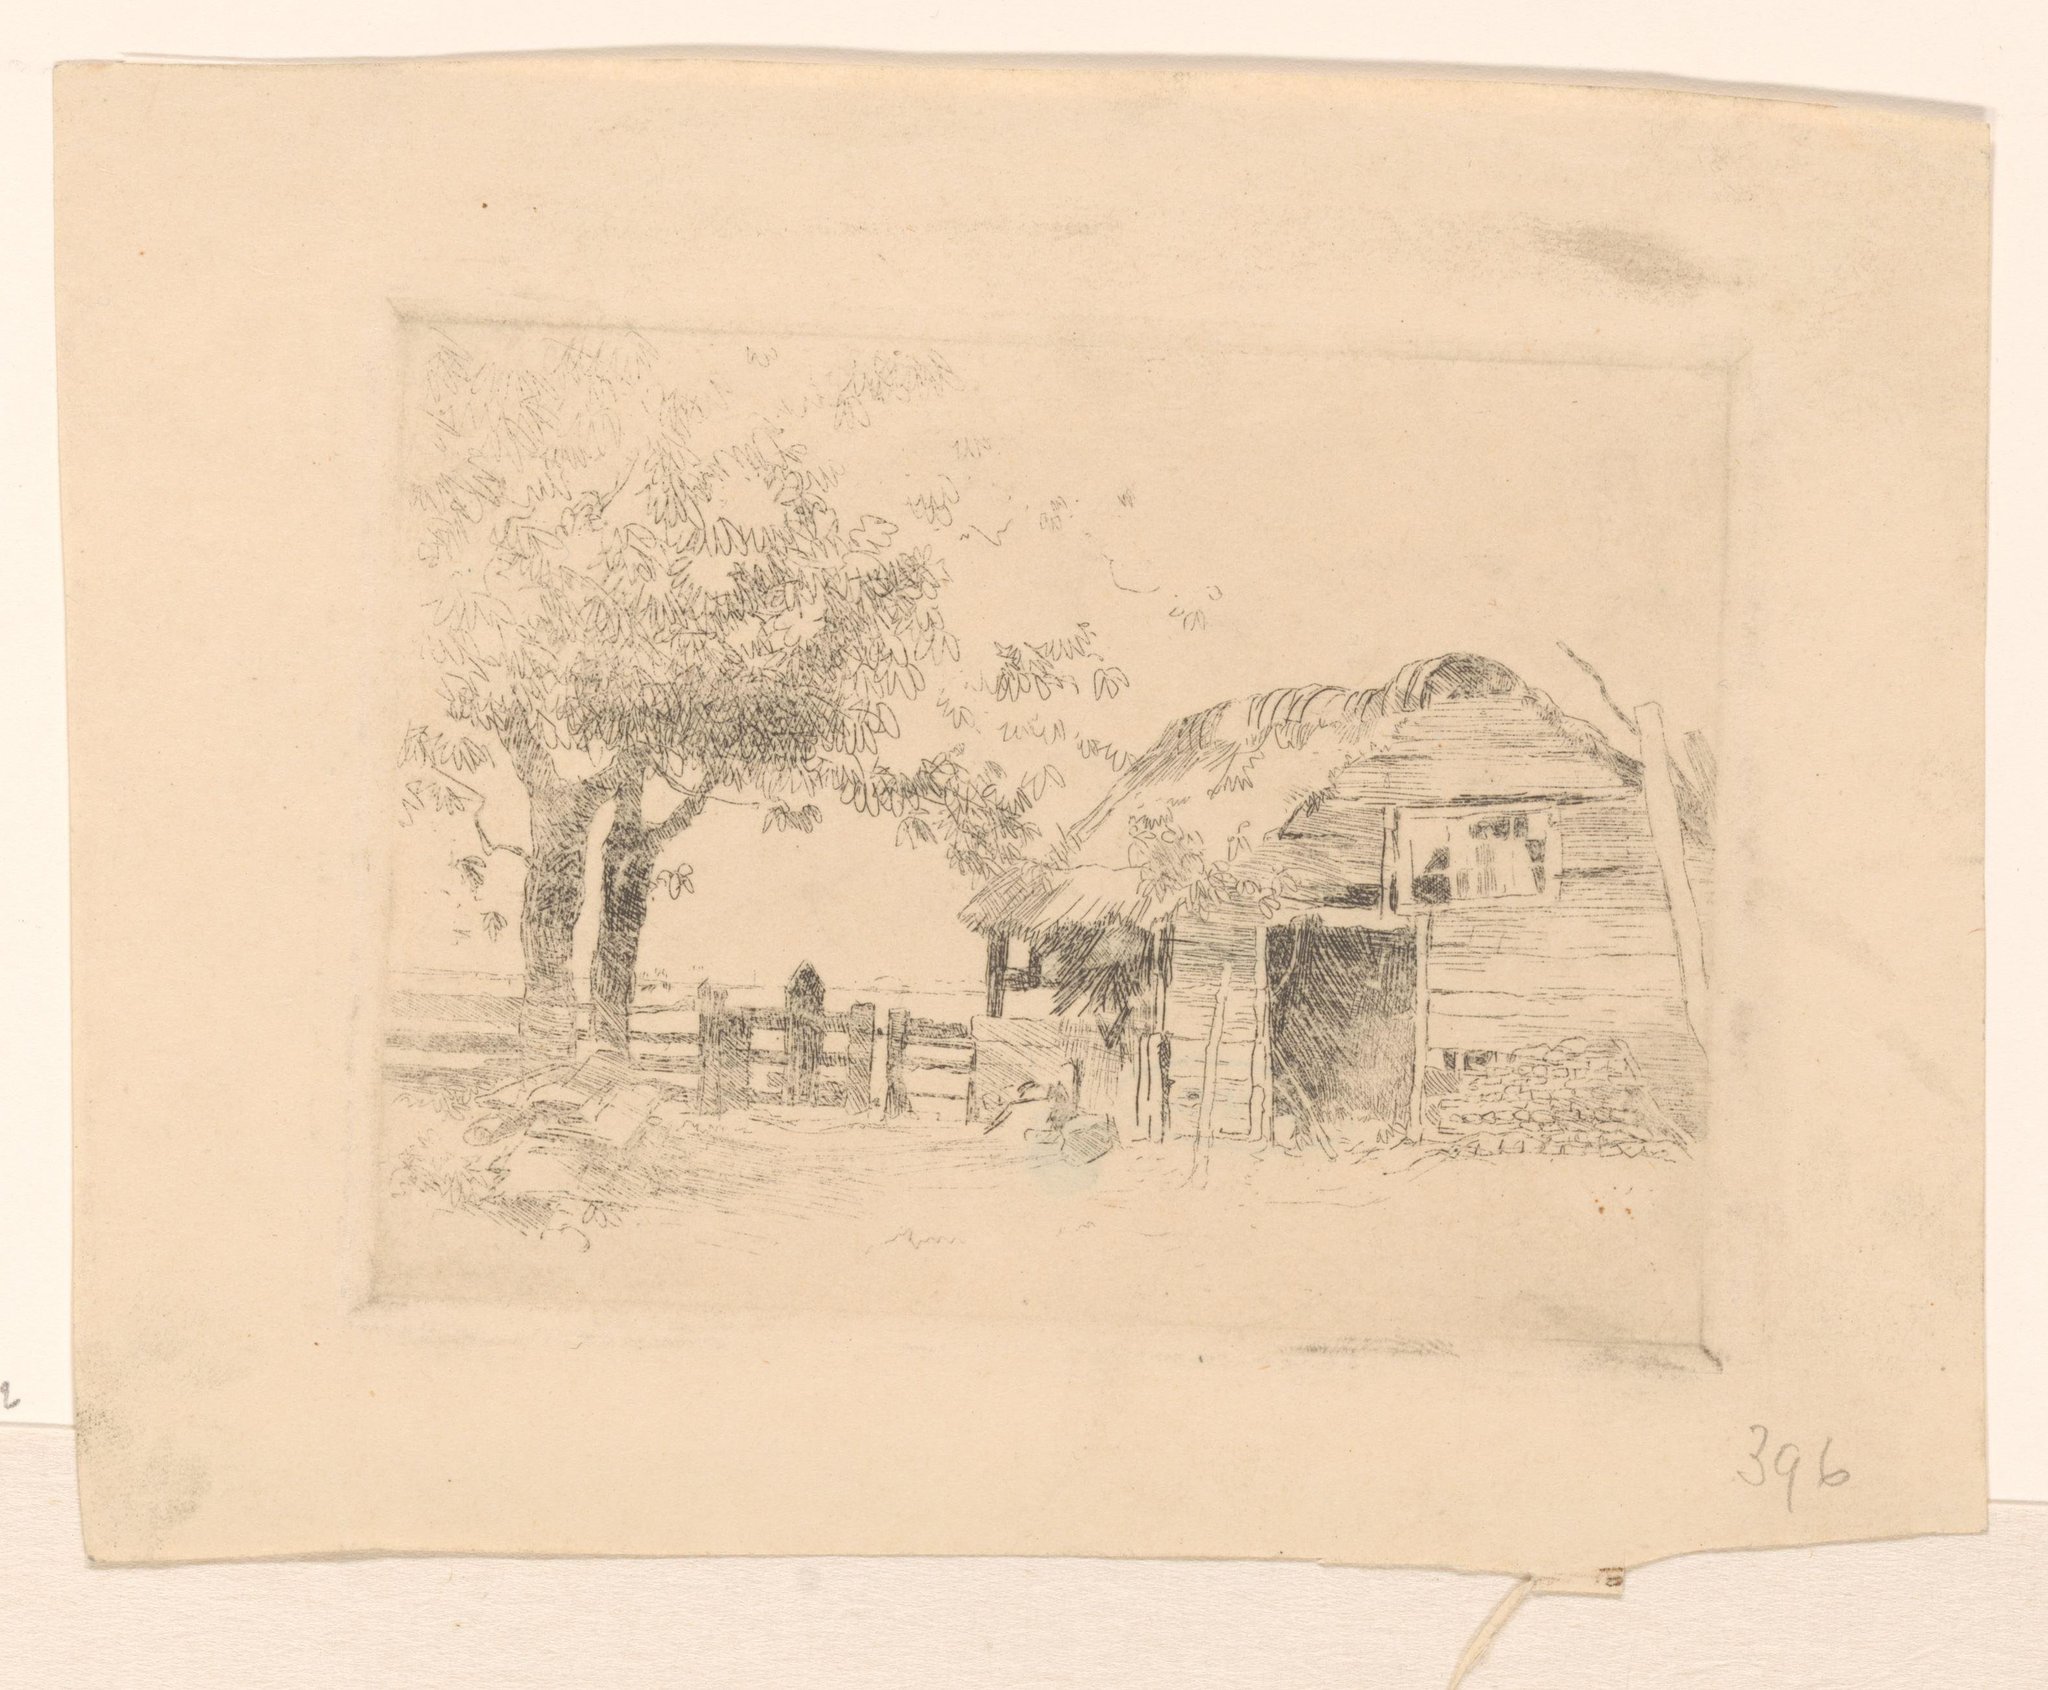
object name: print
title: Oude schuur met rieten dak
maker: cornelis vreedenburgh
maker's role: draughtsman, print maker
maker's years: 1880-1946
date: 1890-1946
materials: paper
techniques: etching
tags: barn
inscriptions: collector's mark: Lugt 2228, collector's mark: Lugt 2760